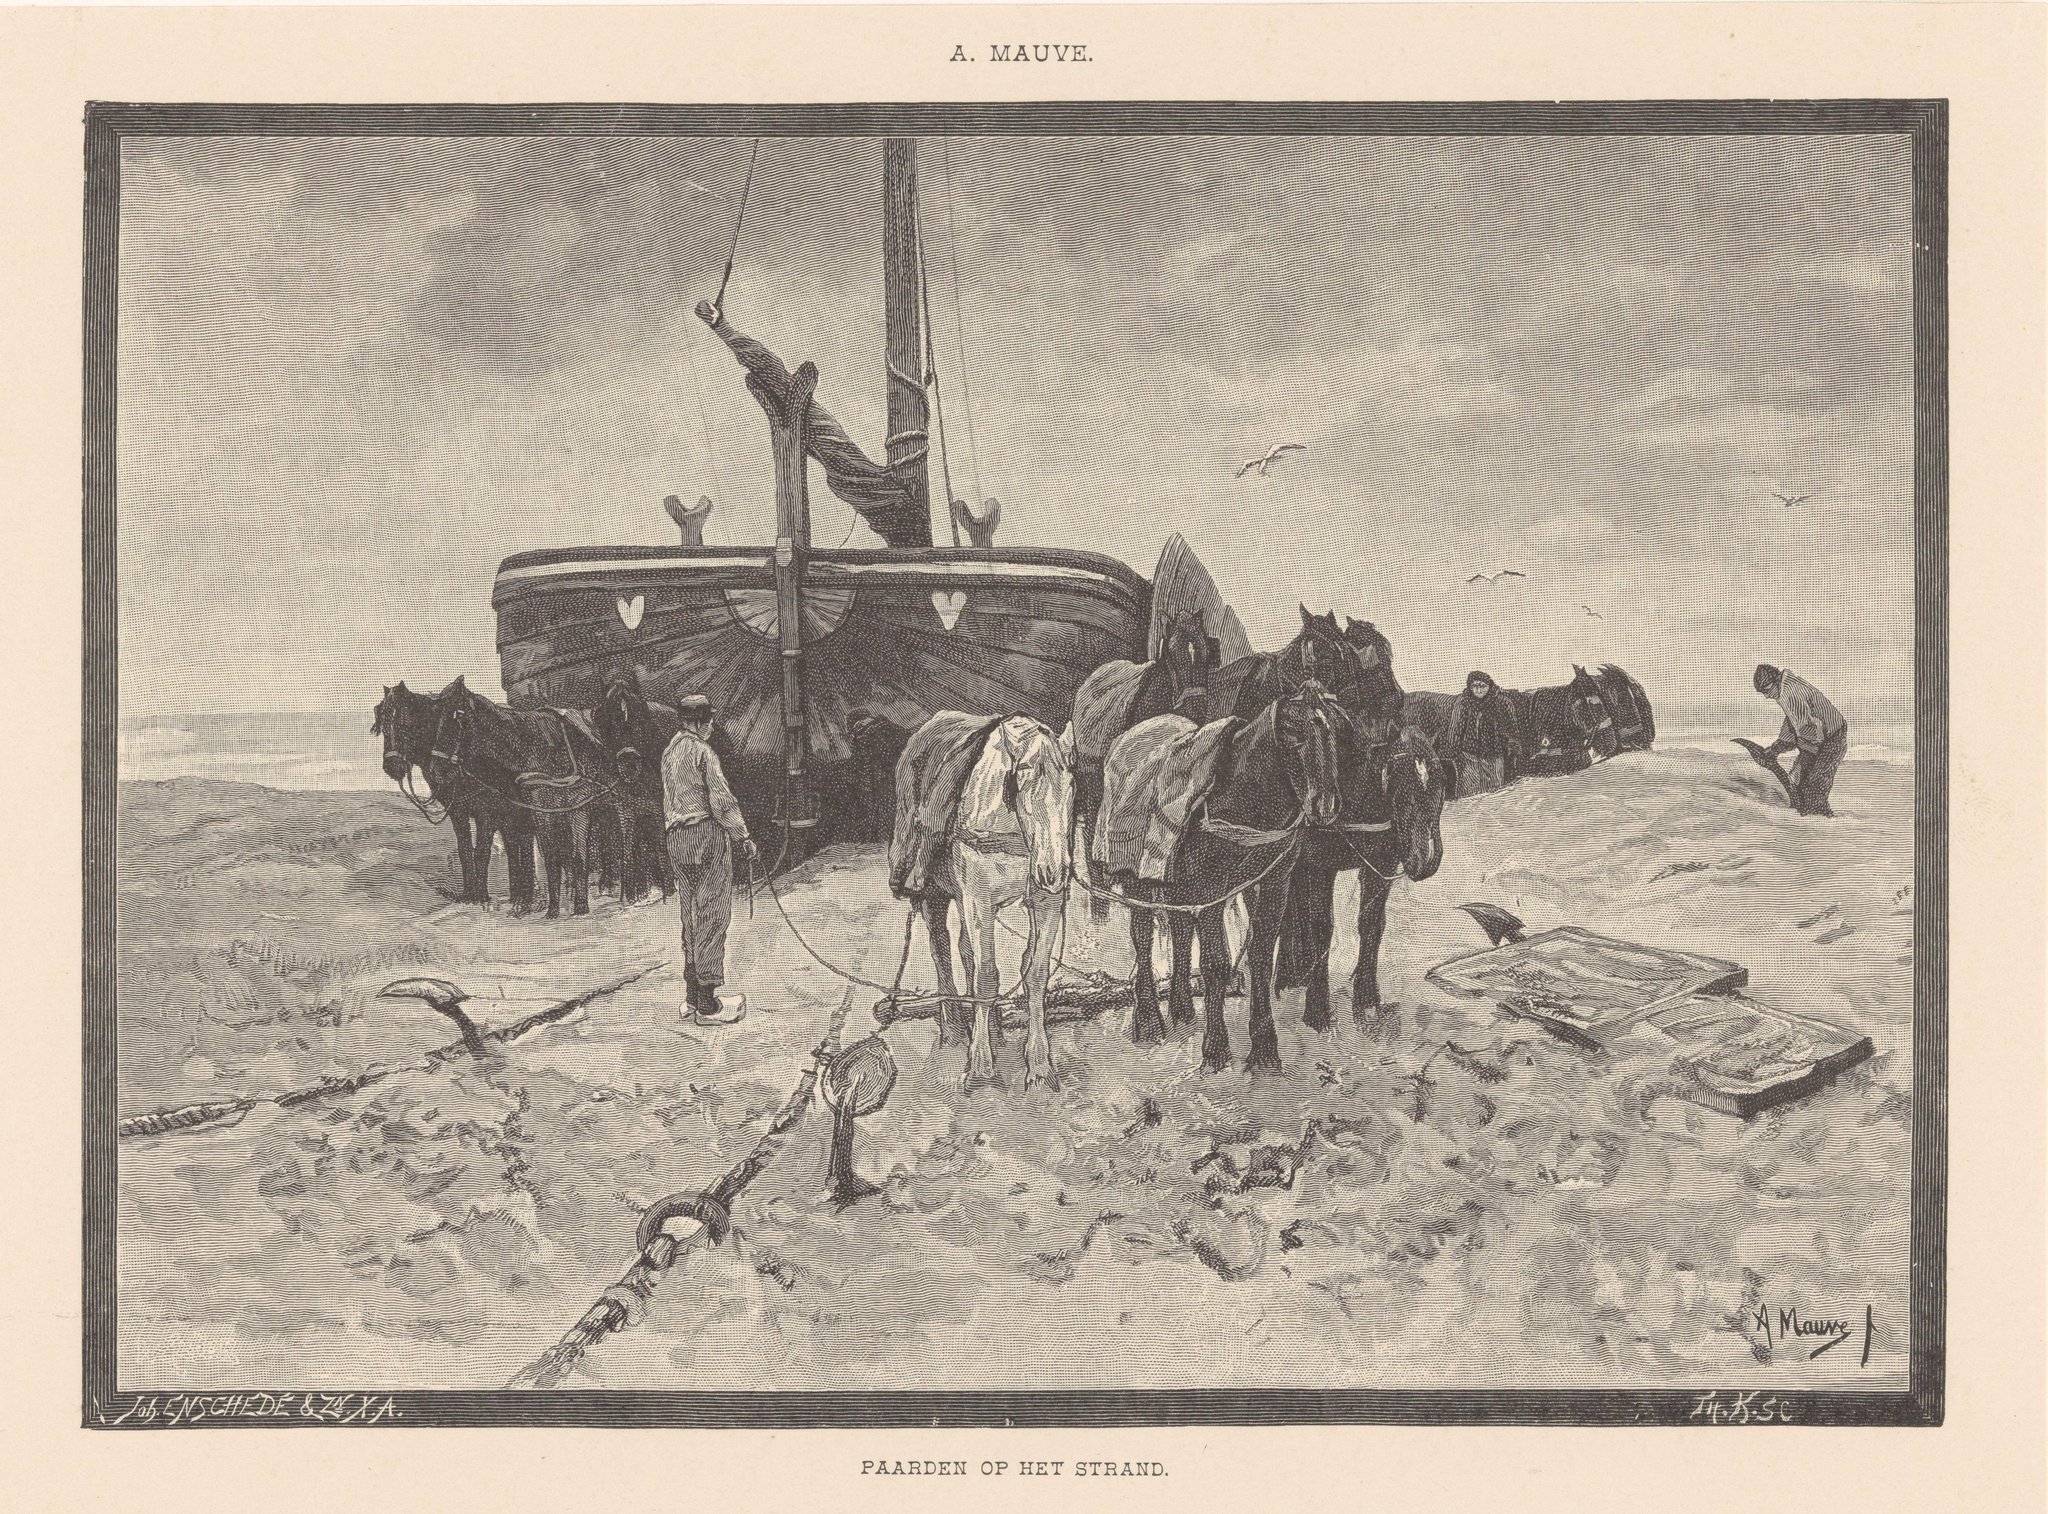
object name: print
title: Paarden op het strand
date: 1869-1904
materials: paper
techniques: lithograph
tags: ships (in general), horse, beach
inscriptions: collector's mark: Lugt 2228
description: Een bomschuit met paarden op het strand.